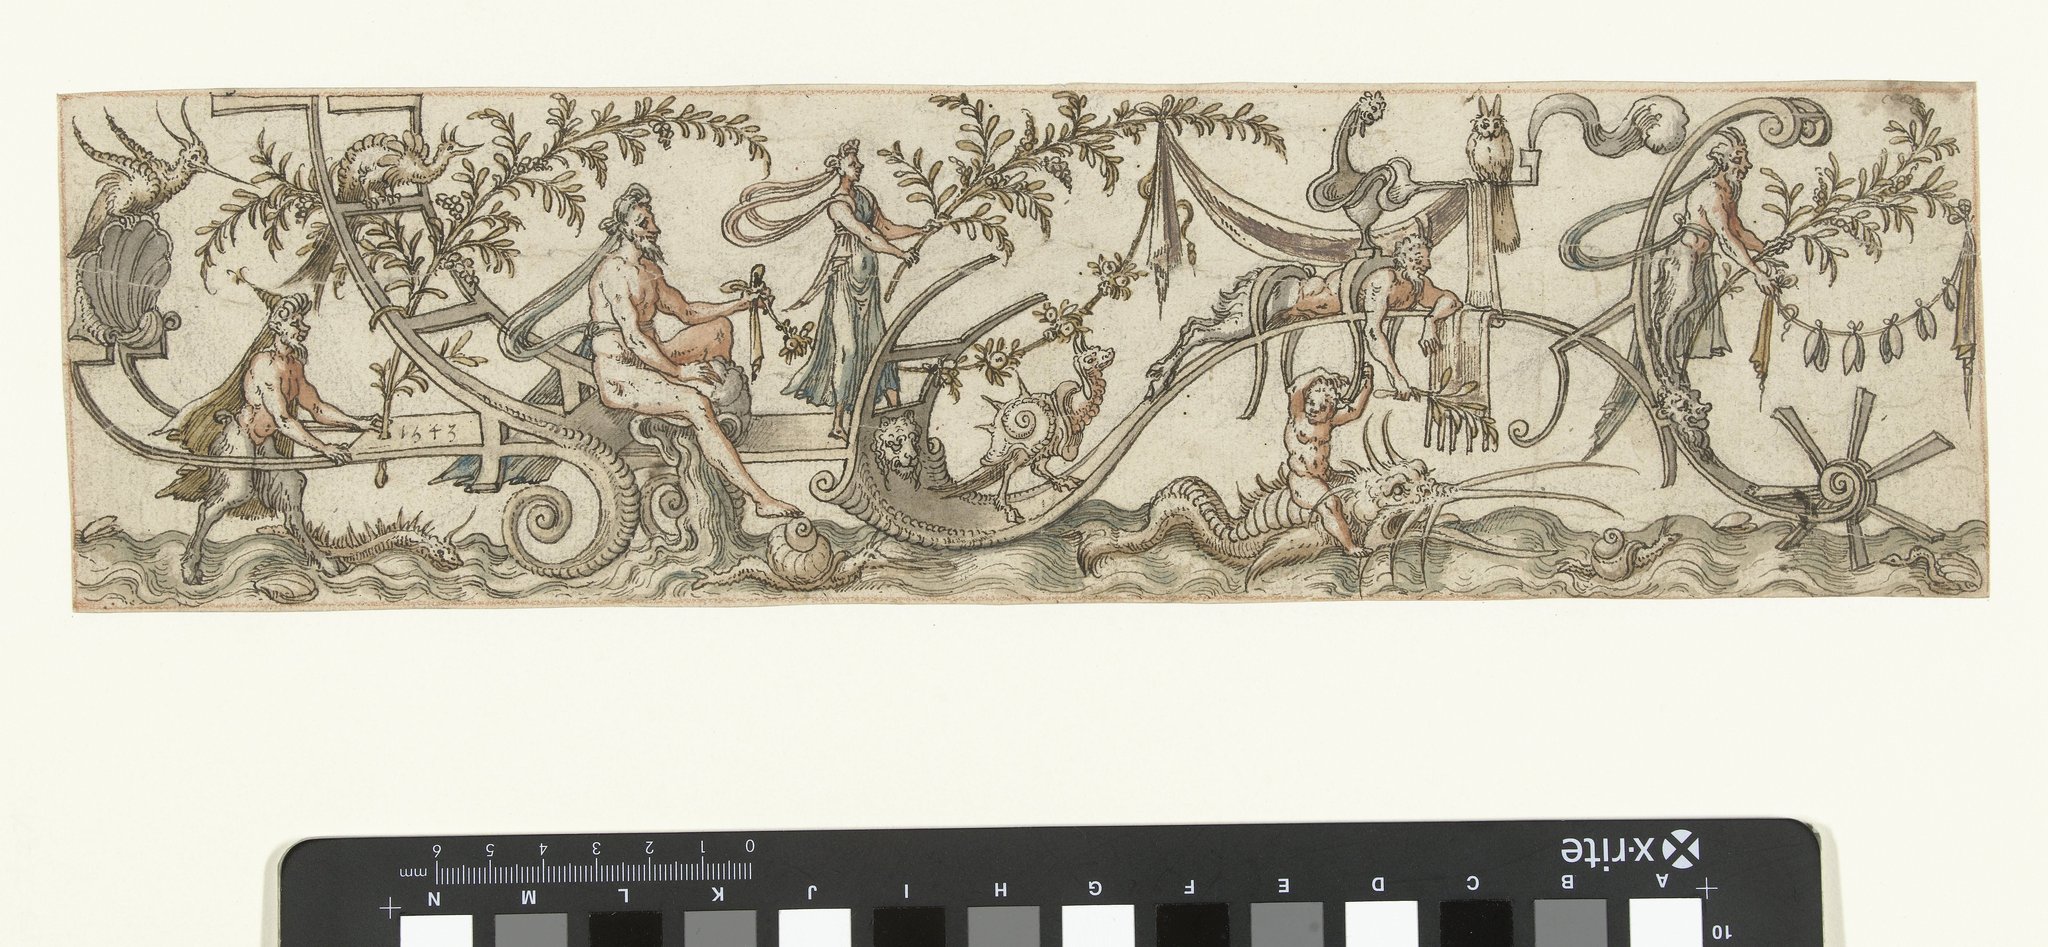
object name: drawing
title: Fantasiestrijdwagen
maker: cornelis floris (ii)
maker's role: draughtsman, print maker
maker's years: 1514-1575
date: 1543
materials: ink, paper, watercolor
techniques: brush, pen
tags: ornament ~ hybrid animals, anthropomorphic ornament, chariot, triumphal car, ornament derived from plant forms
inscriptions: date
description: Fantasiestrijdwagen met een riviergod, drie centauren, een vrouw en een jongen op een zeemonster.